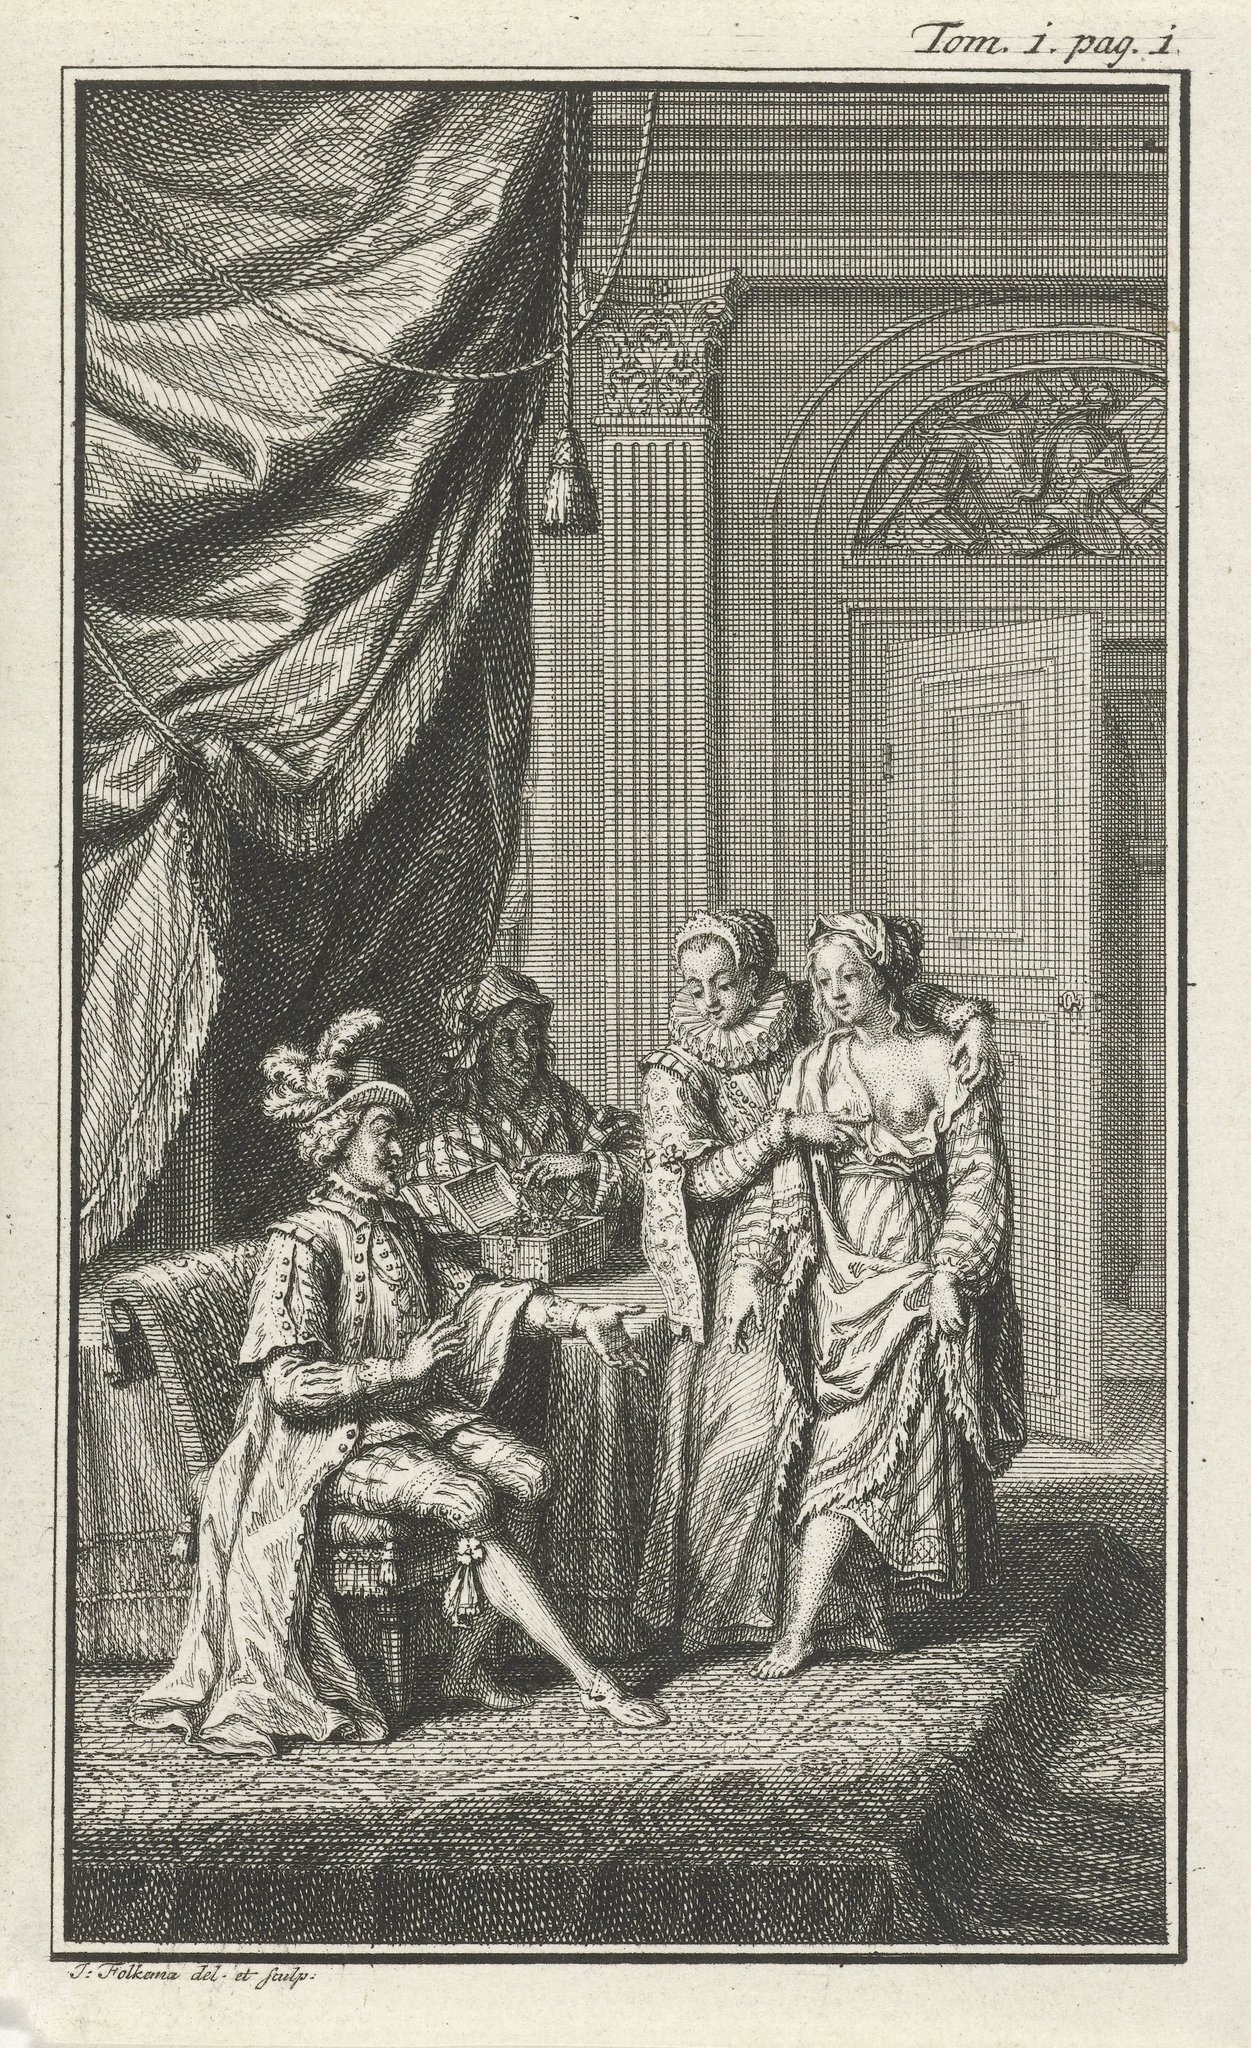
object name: book illustration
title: Spaanse Heidin Pretiosa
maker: jacob folkema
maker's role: draughtsman, print maker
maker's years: 1692-1767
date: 1702-1767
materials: paper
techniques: etching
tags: wandering communities: romani or roma, preciosa, whore, prostitute, hand uncovering the chest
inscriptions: collector's mark: Lugt 240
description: De Spaanse heidin Preciosa staat voor een rijk geklede man. Een vrouw ontbloot een borst van Preciosa. Achter dit drietal steelt een oudere vrouw sierraden uit een kistje dat voor haar op tafel staat. Prent rechtsboven gemerkt: Tom. i. pag. i. Het Spaanse heidinnetje Preciosa en de vrouw zijn figuren ontleend aan het verhaal ‘La Gitanella’ van Miguel de Cervantes uit 1613, in Nederland bekend als ‘Het Spaans Heidinnetje’. Heiden en heidin waren eigentijdse benamingen voor het Roma-volk.